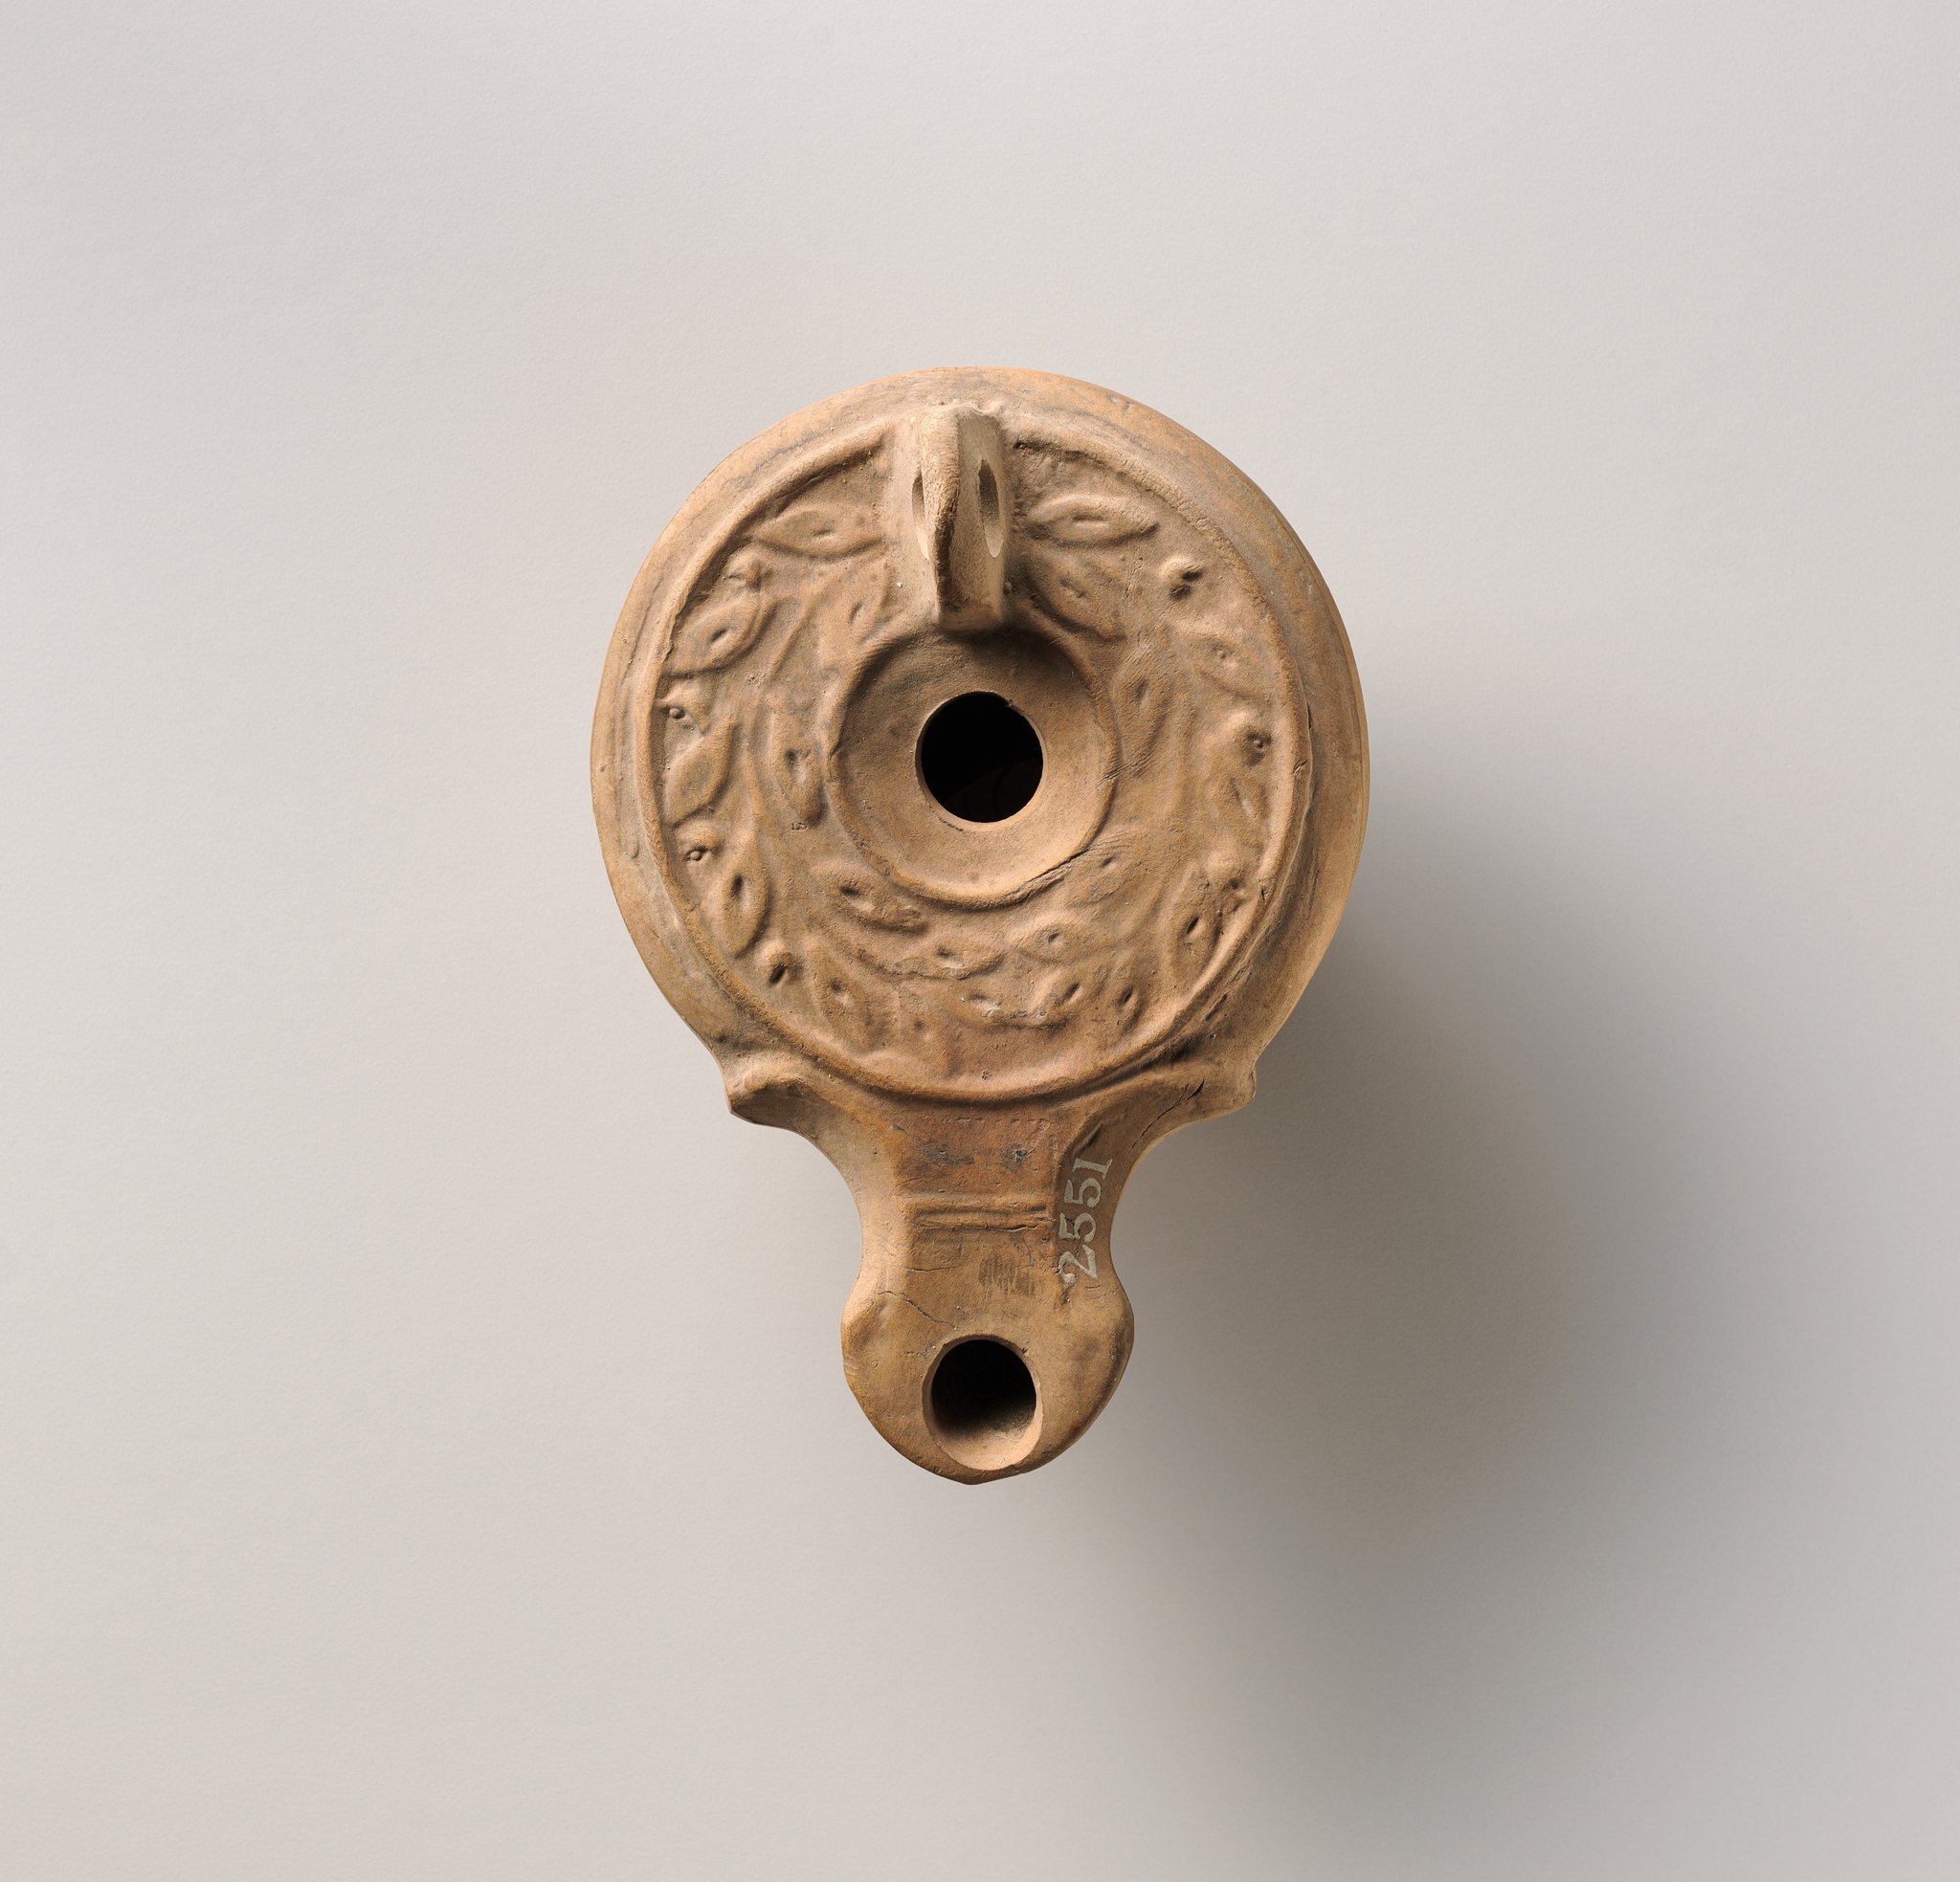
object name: lamp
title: Terracotta oil lamp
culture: roman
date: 201-300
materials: terracotta